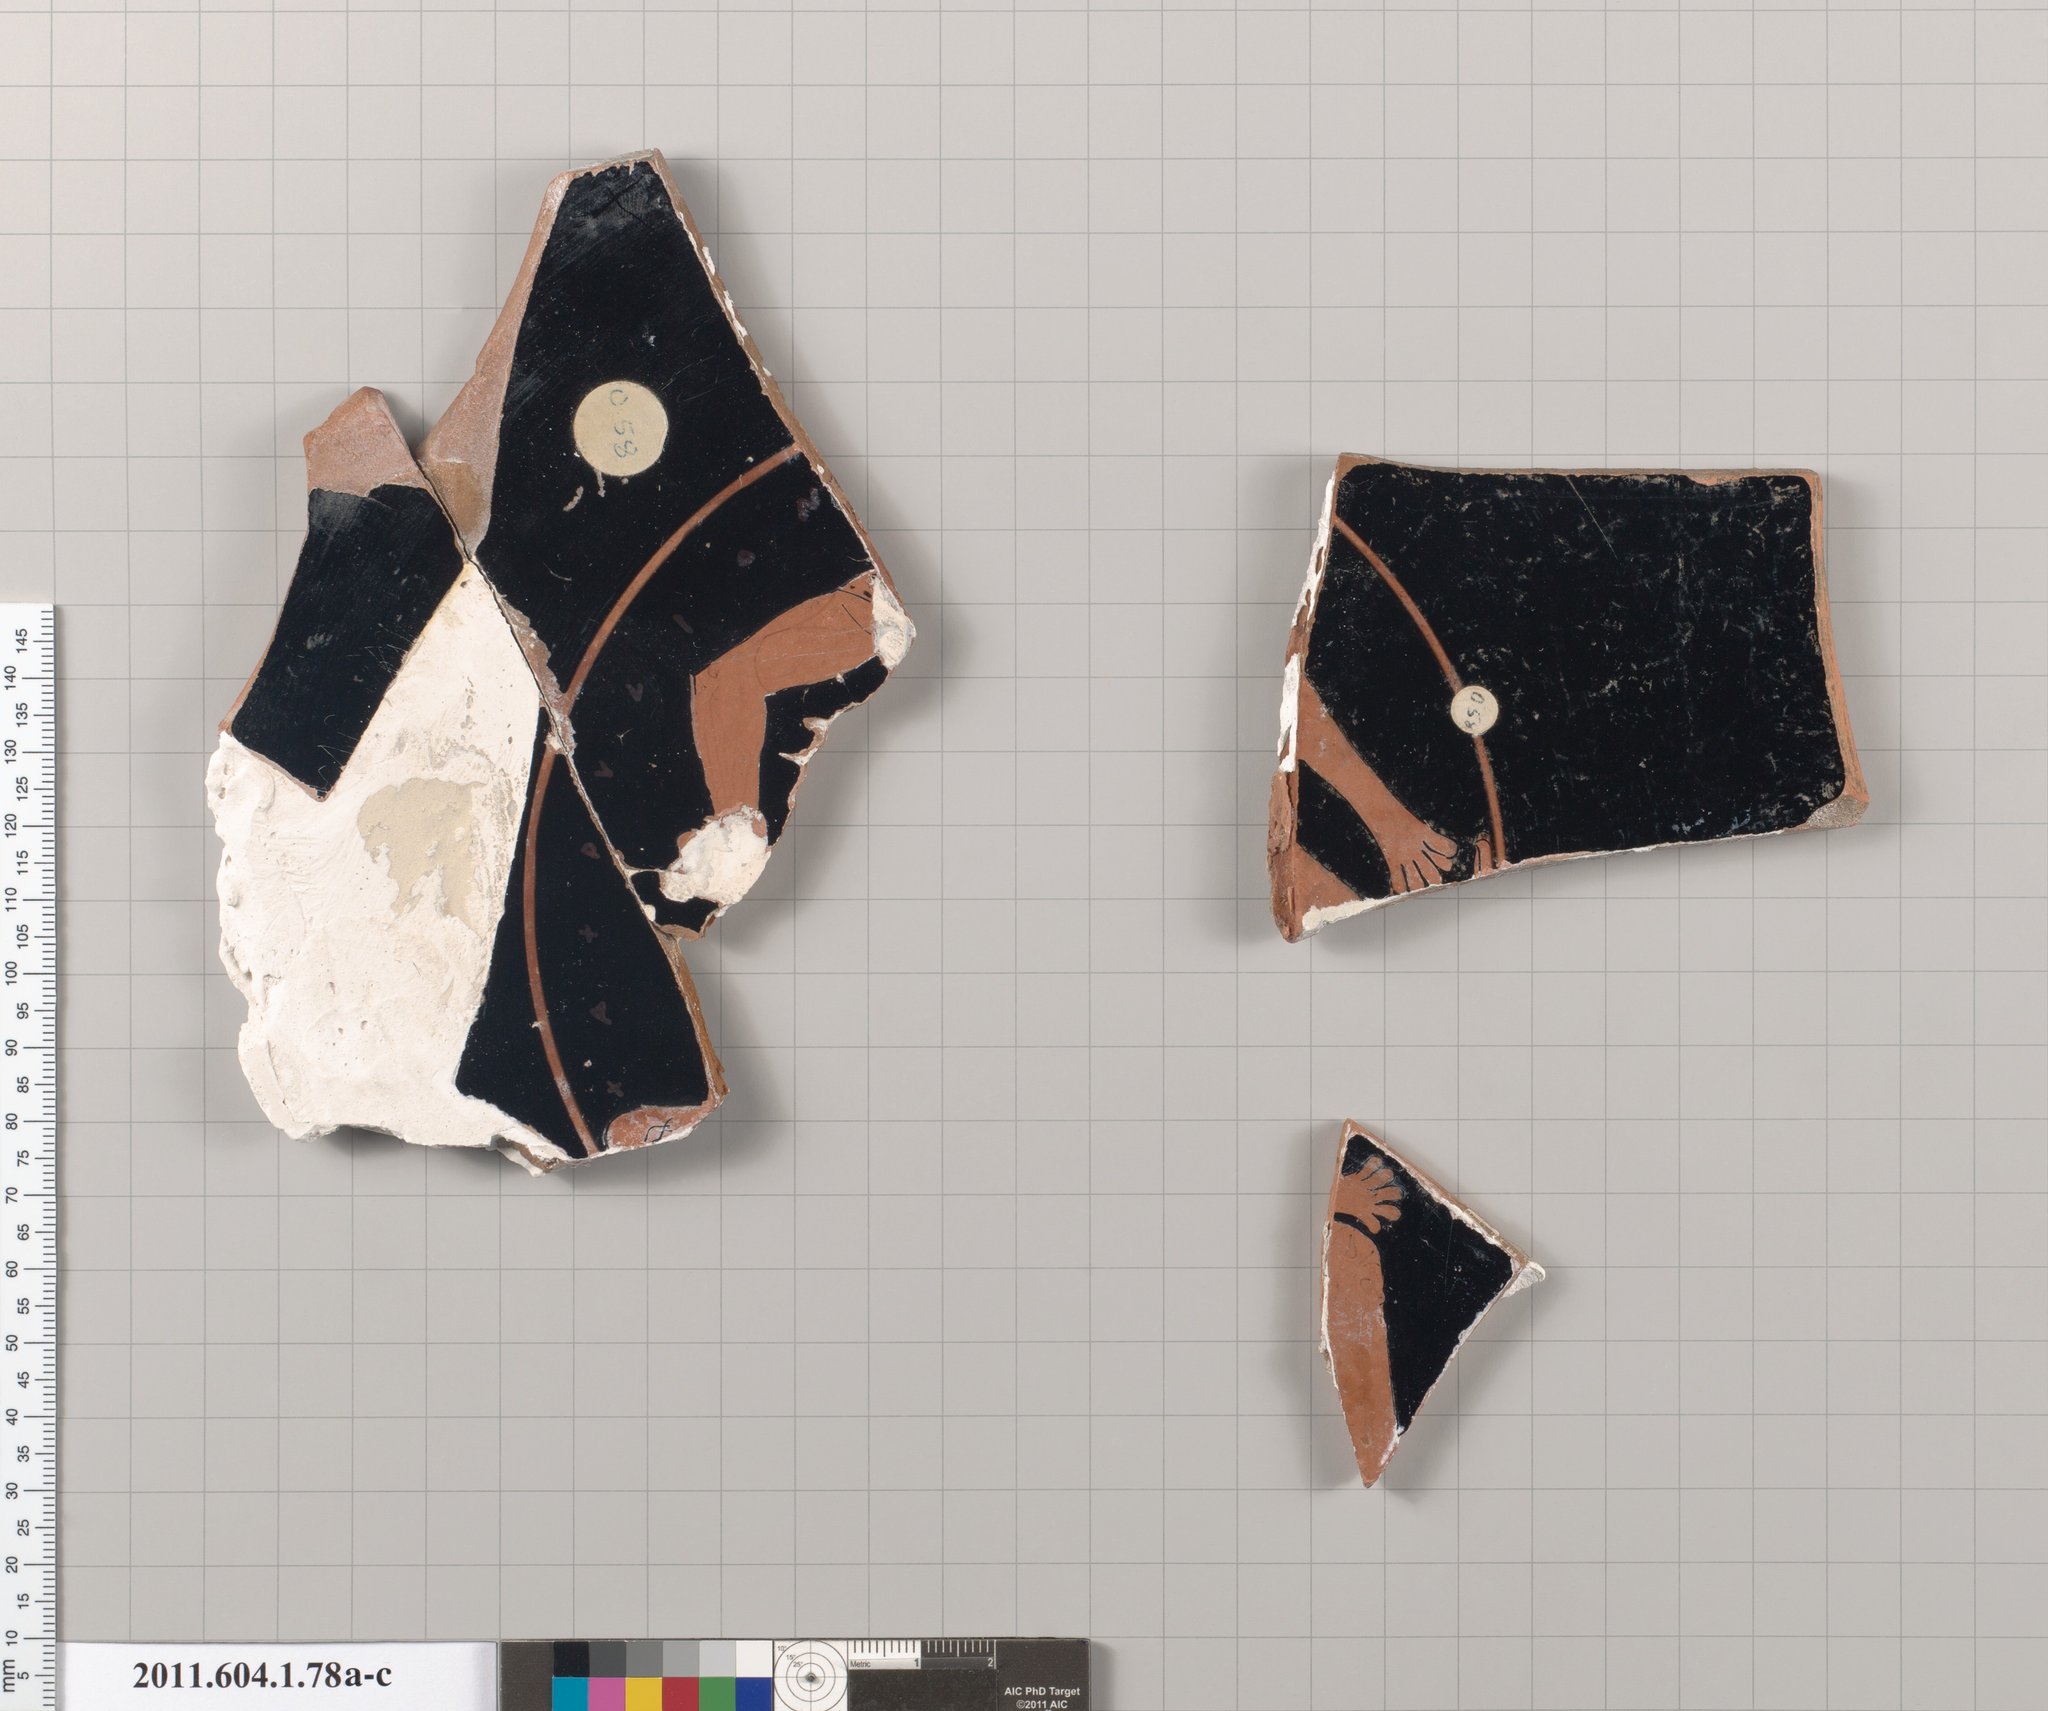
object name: kylix fragment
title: Terracotta fragments of a kylix (drinking cup)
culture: greek, attic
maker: kachrylion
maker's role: artist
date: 520-500 BCE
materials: terracotta